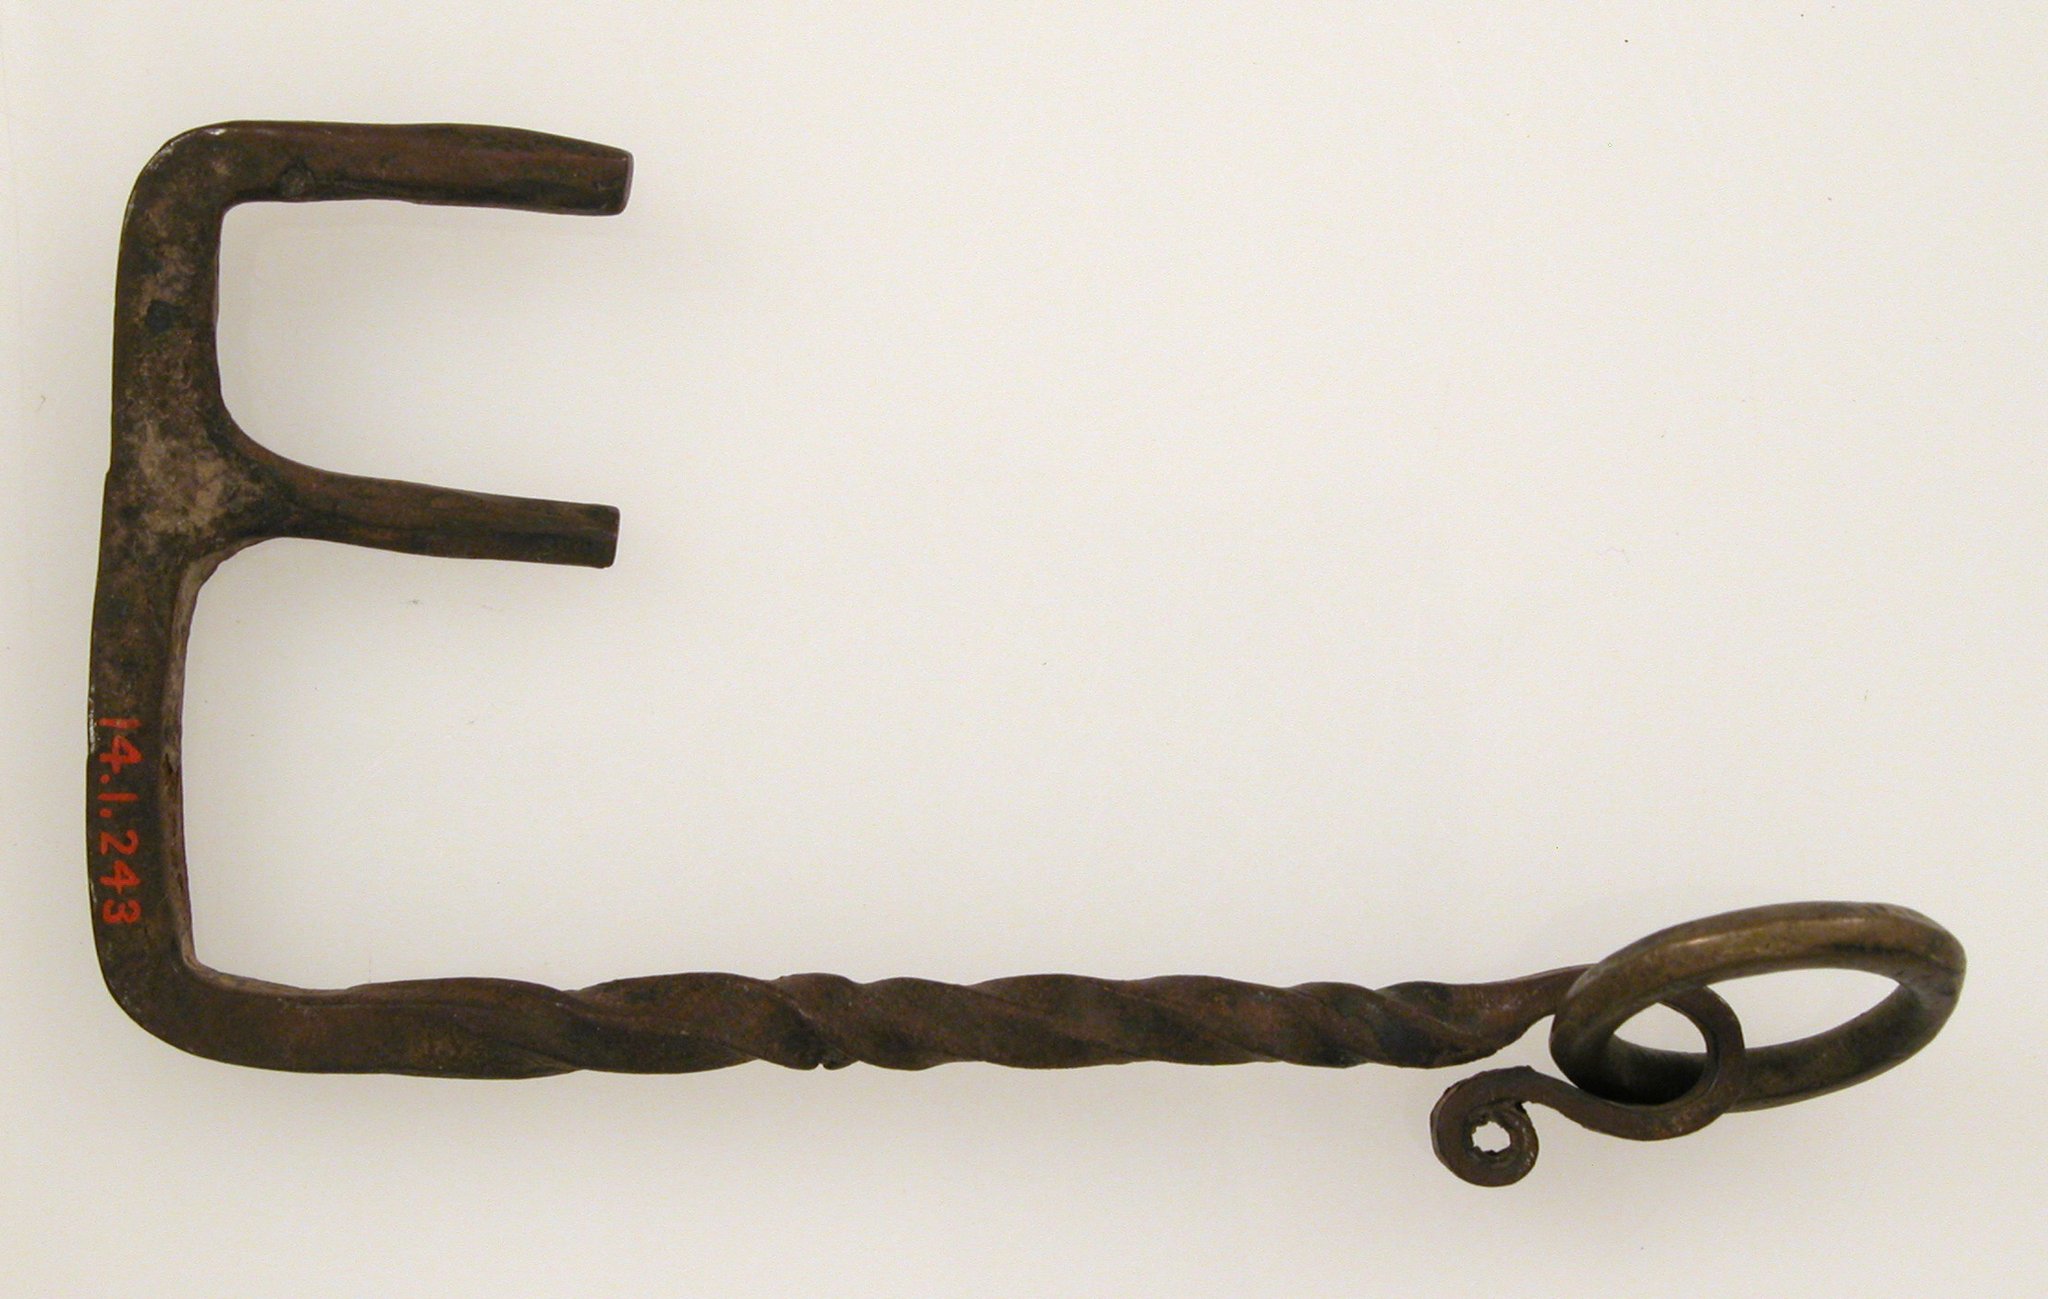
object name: key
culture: coptic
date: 580-640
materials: copper alloy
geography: egypt